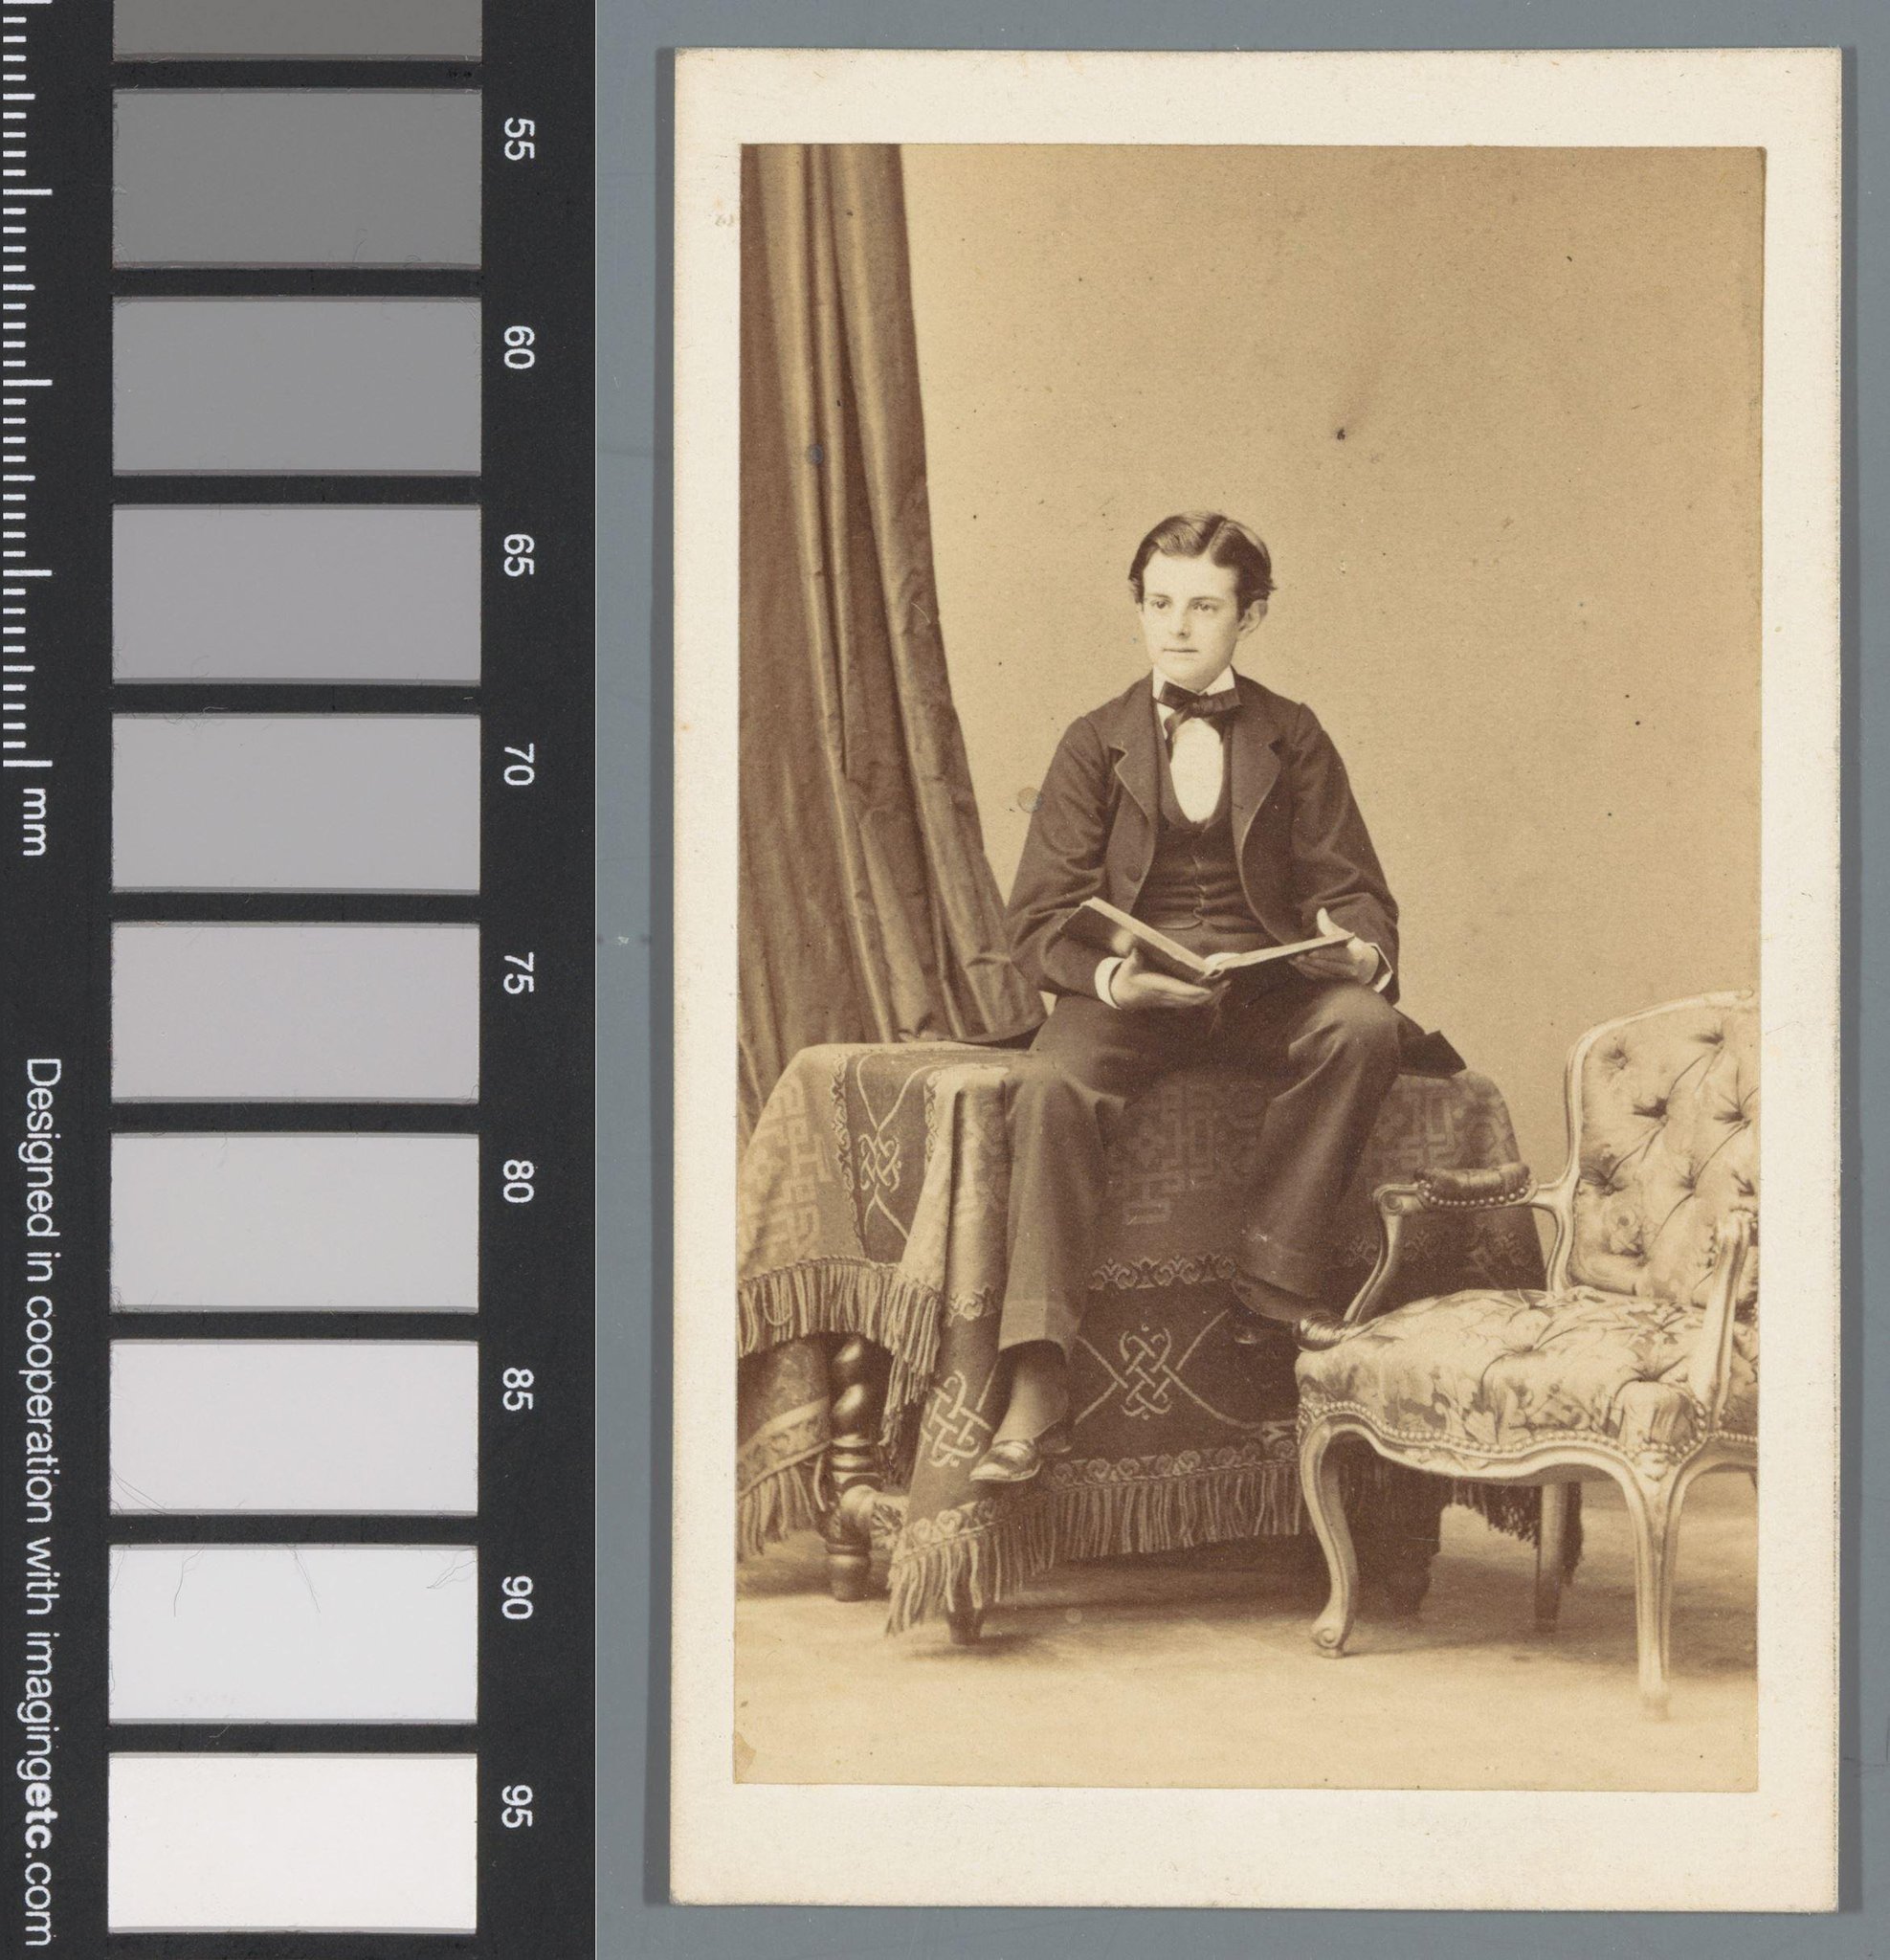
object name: carte de visite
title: Portret van een onbekende jongen, zittend op tafel met een opengeslagen boek in zijn handen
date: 1854-1889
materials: cardboard, paper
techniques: albumen print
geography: paris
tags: seating furniture, boy (child between toddler and youth), historical persons, book - mm - book open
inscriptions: stamp: ‘DISDERI & Cie/ PHOTOGRAPHE de S.M.L'EMPEREUR/ 8, Boulevart des Italiens,/ PARIS.’